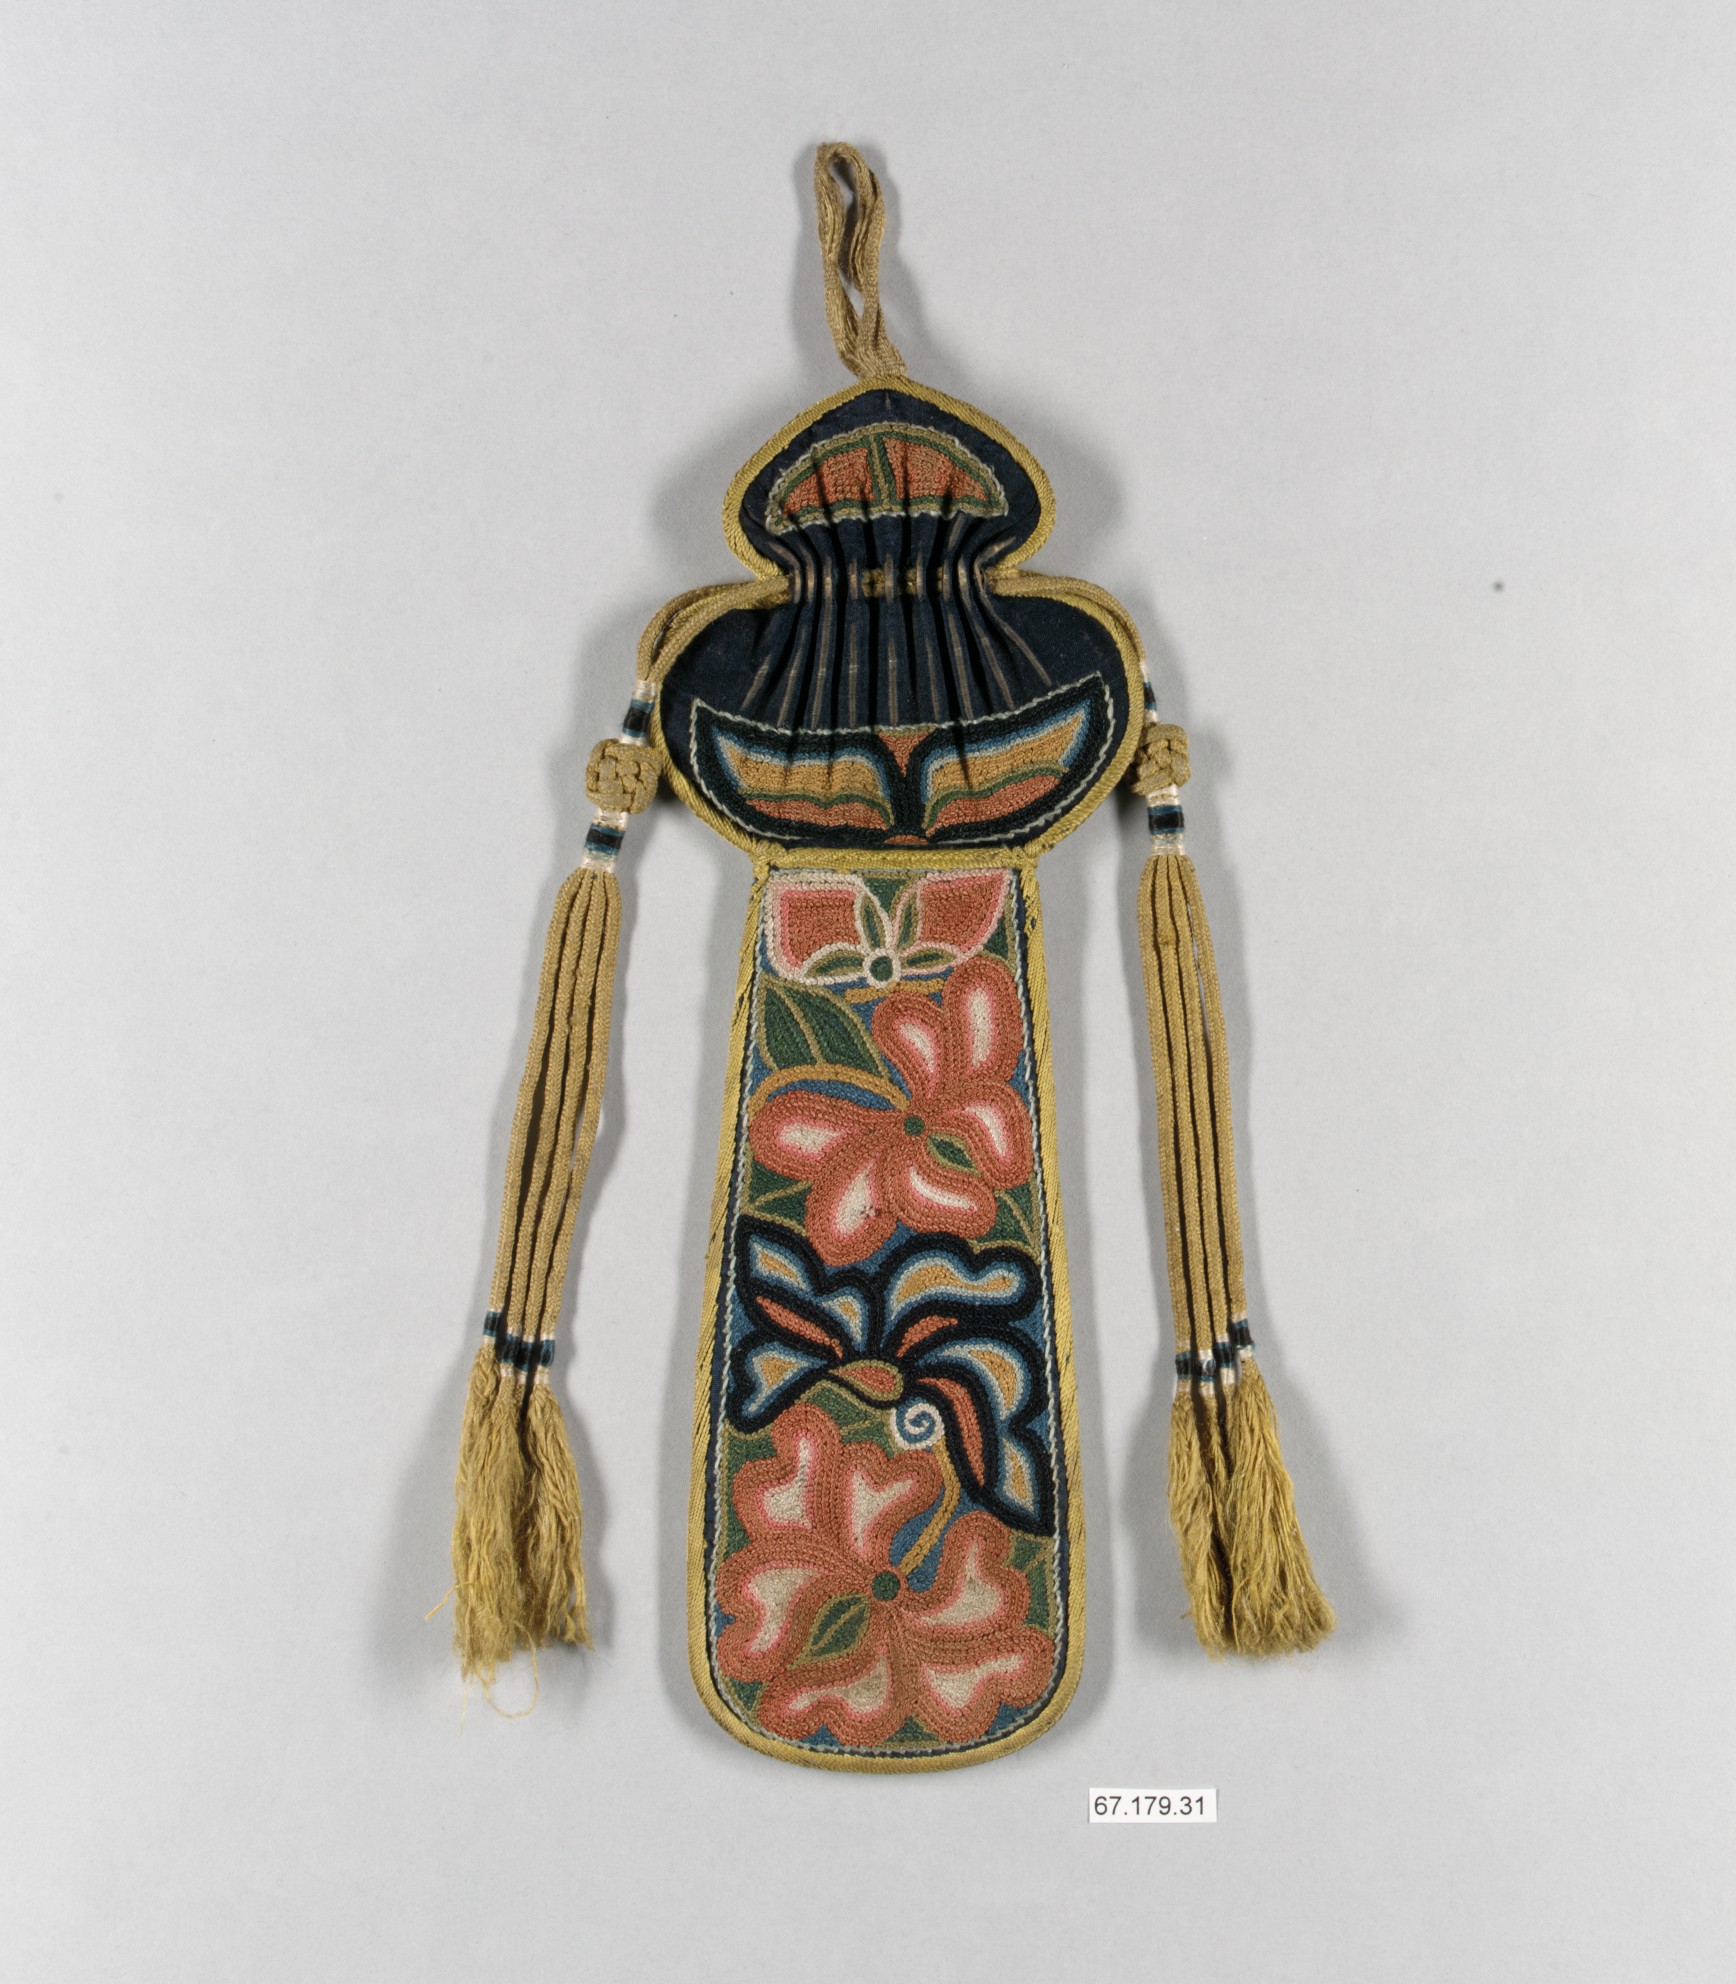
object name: fan case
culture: chinese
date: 1801-1900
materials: silk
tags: flowers